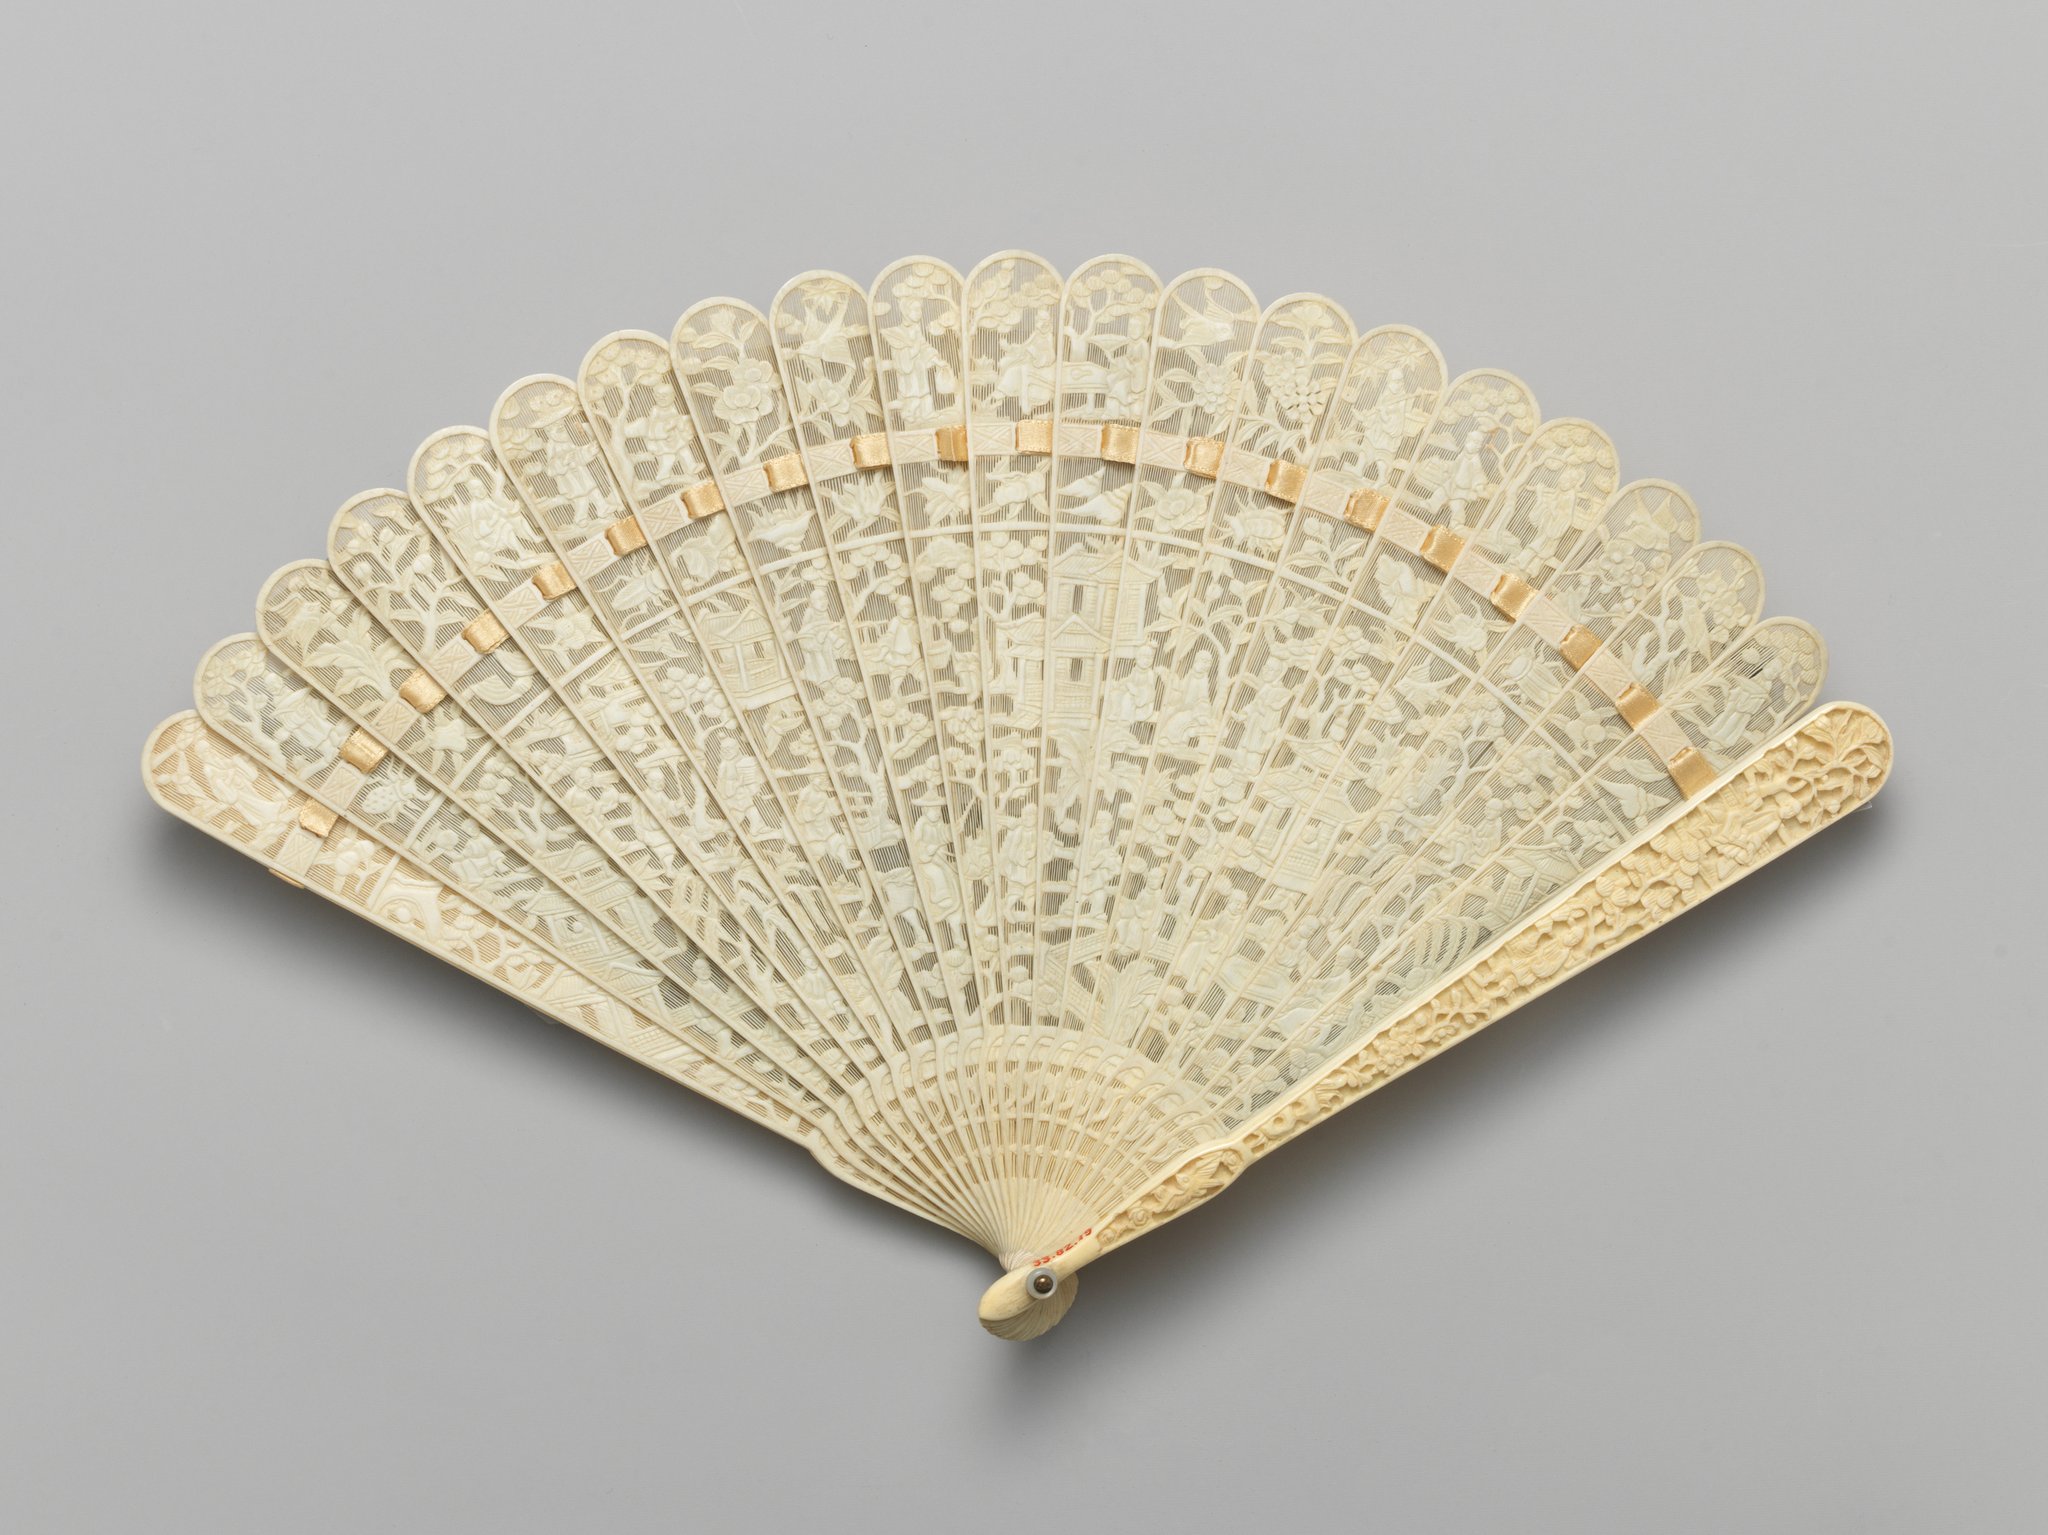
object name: fan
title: Brisé Fan, with Figures and Pavilions in a Landscape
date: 1767-1833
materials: ivory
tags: girls,flowers